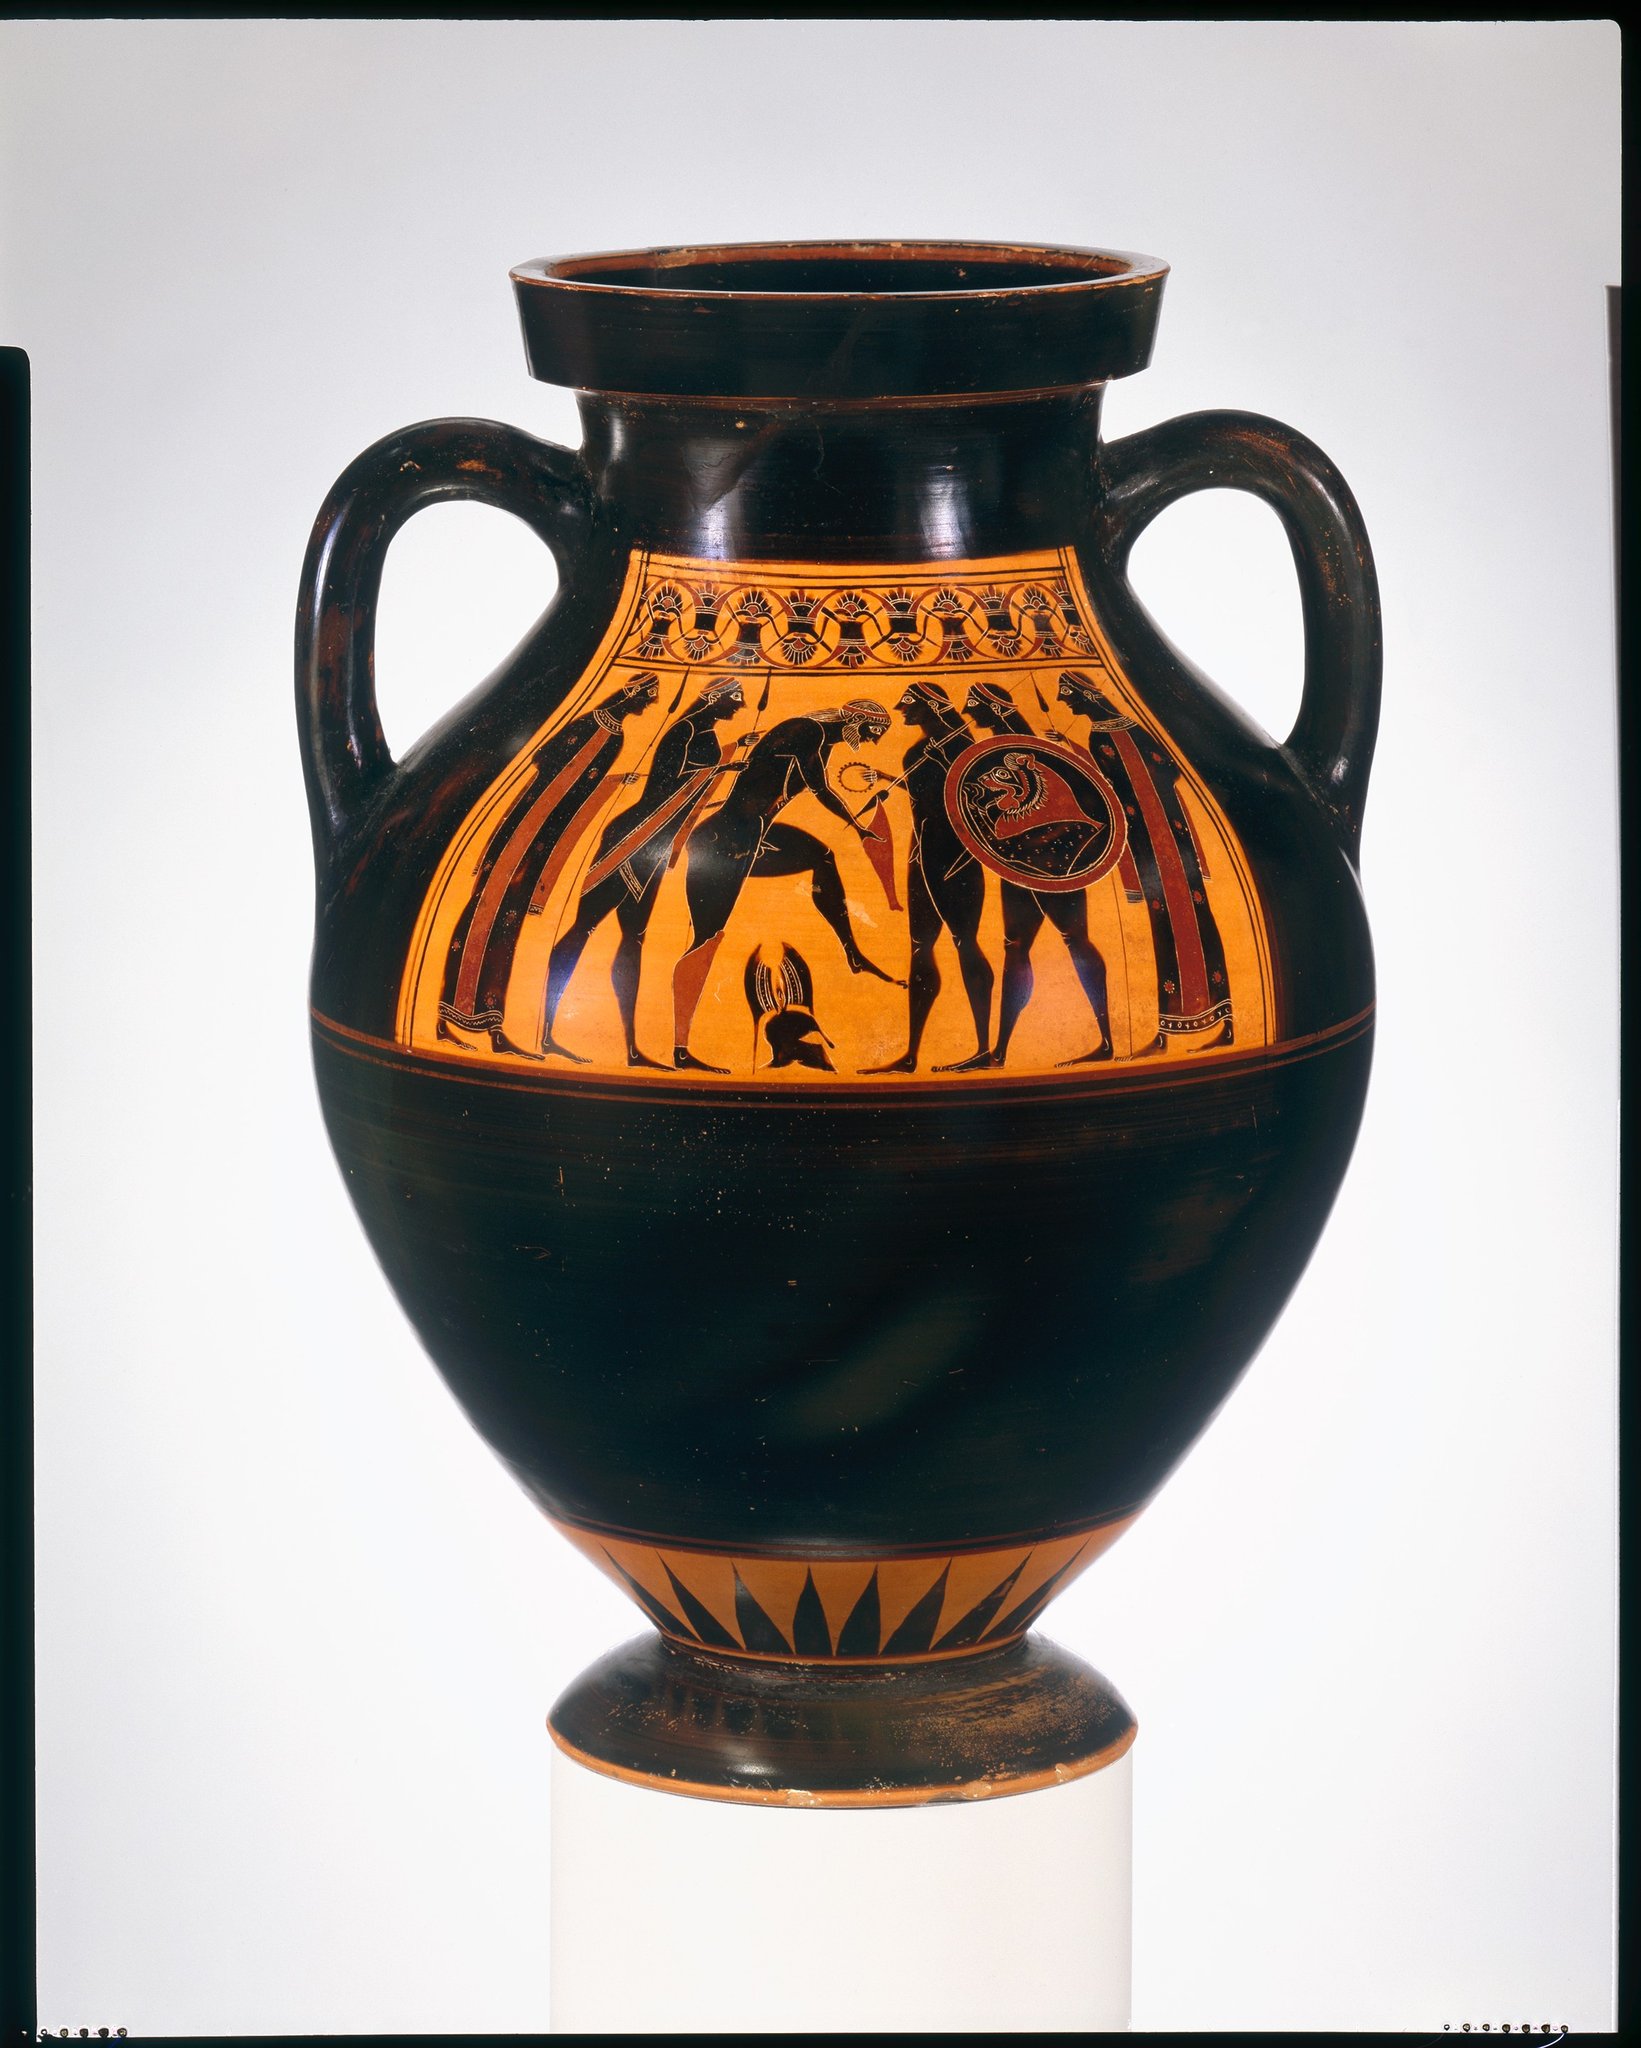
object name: amphora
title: Terracotta amphora (jar)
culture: greek, attic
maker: amasis painter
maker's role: artist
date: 550 BCE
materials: terracotta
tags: armor,helmets,shields,men,warriors